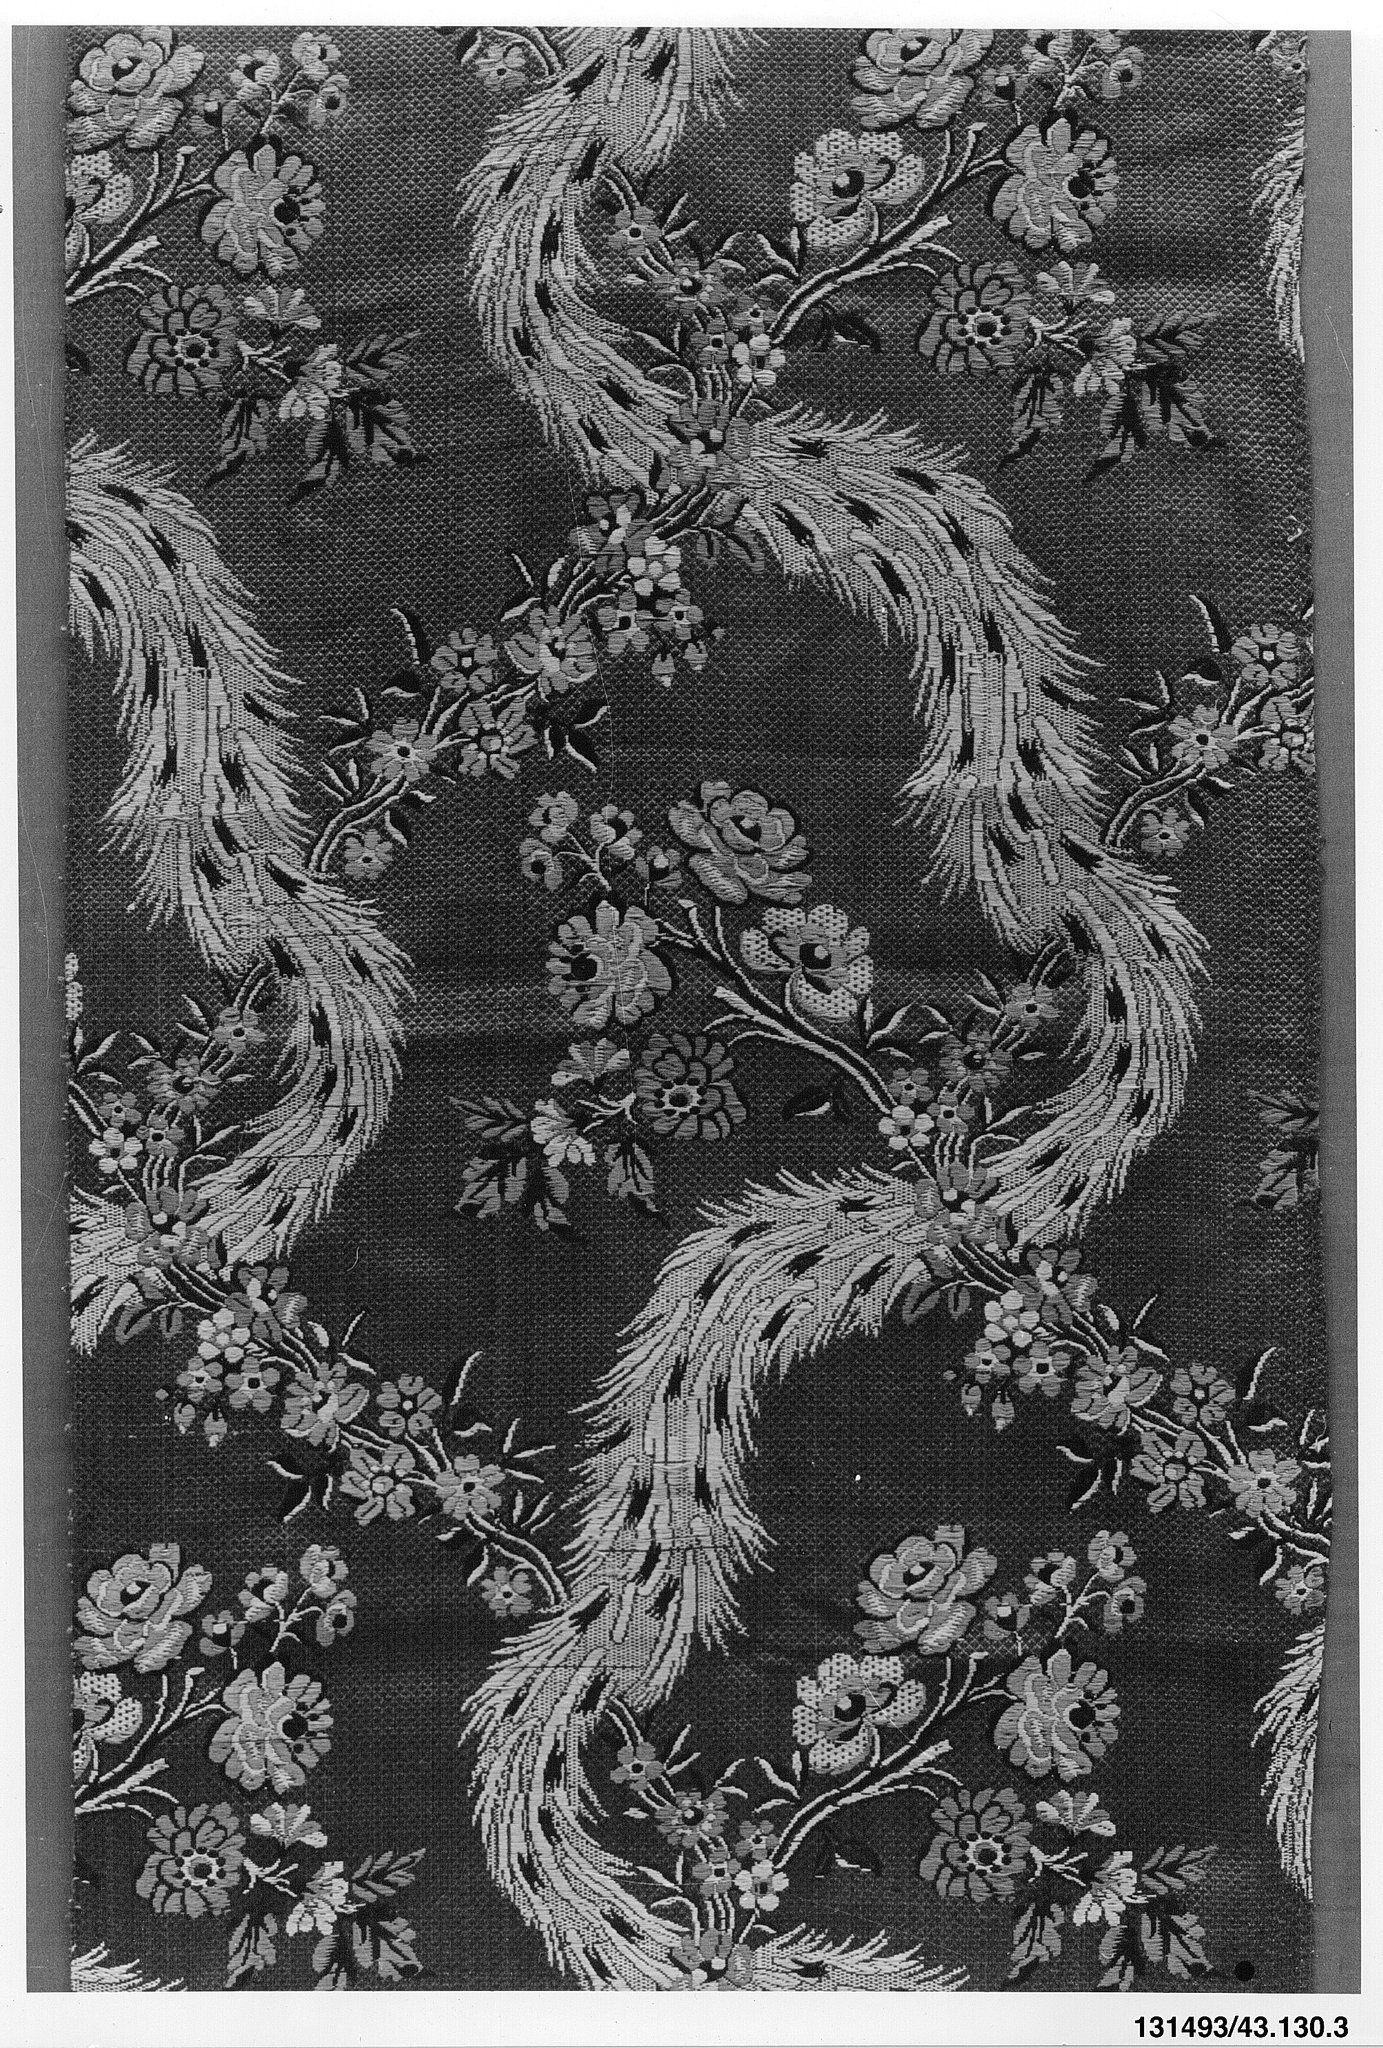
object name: piece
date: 1750-1760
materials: silk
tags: flowers,leaves